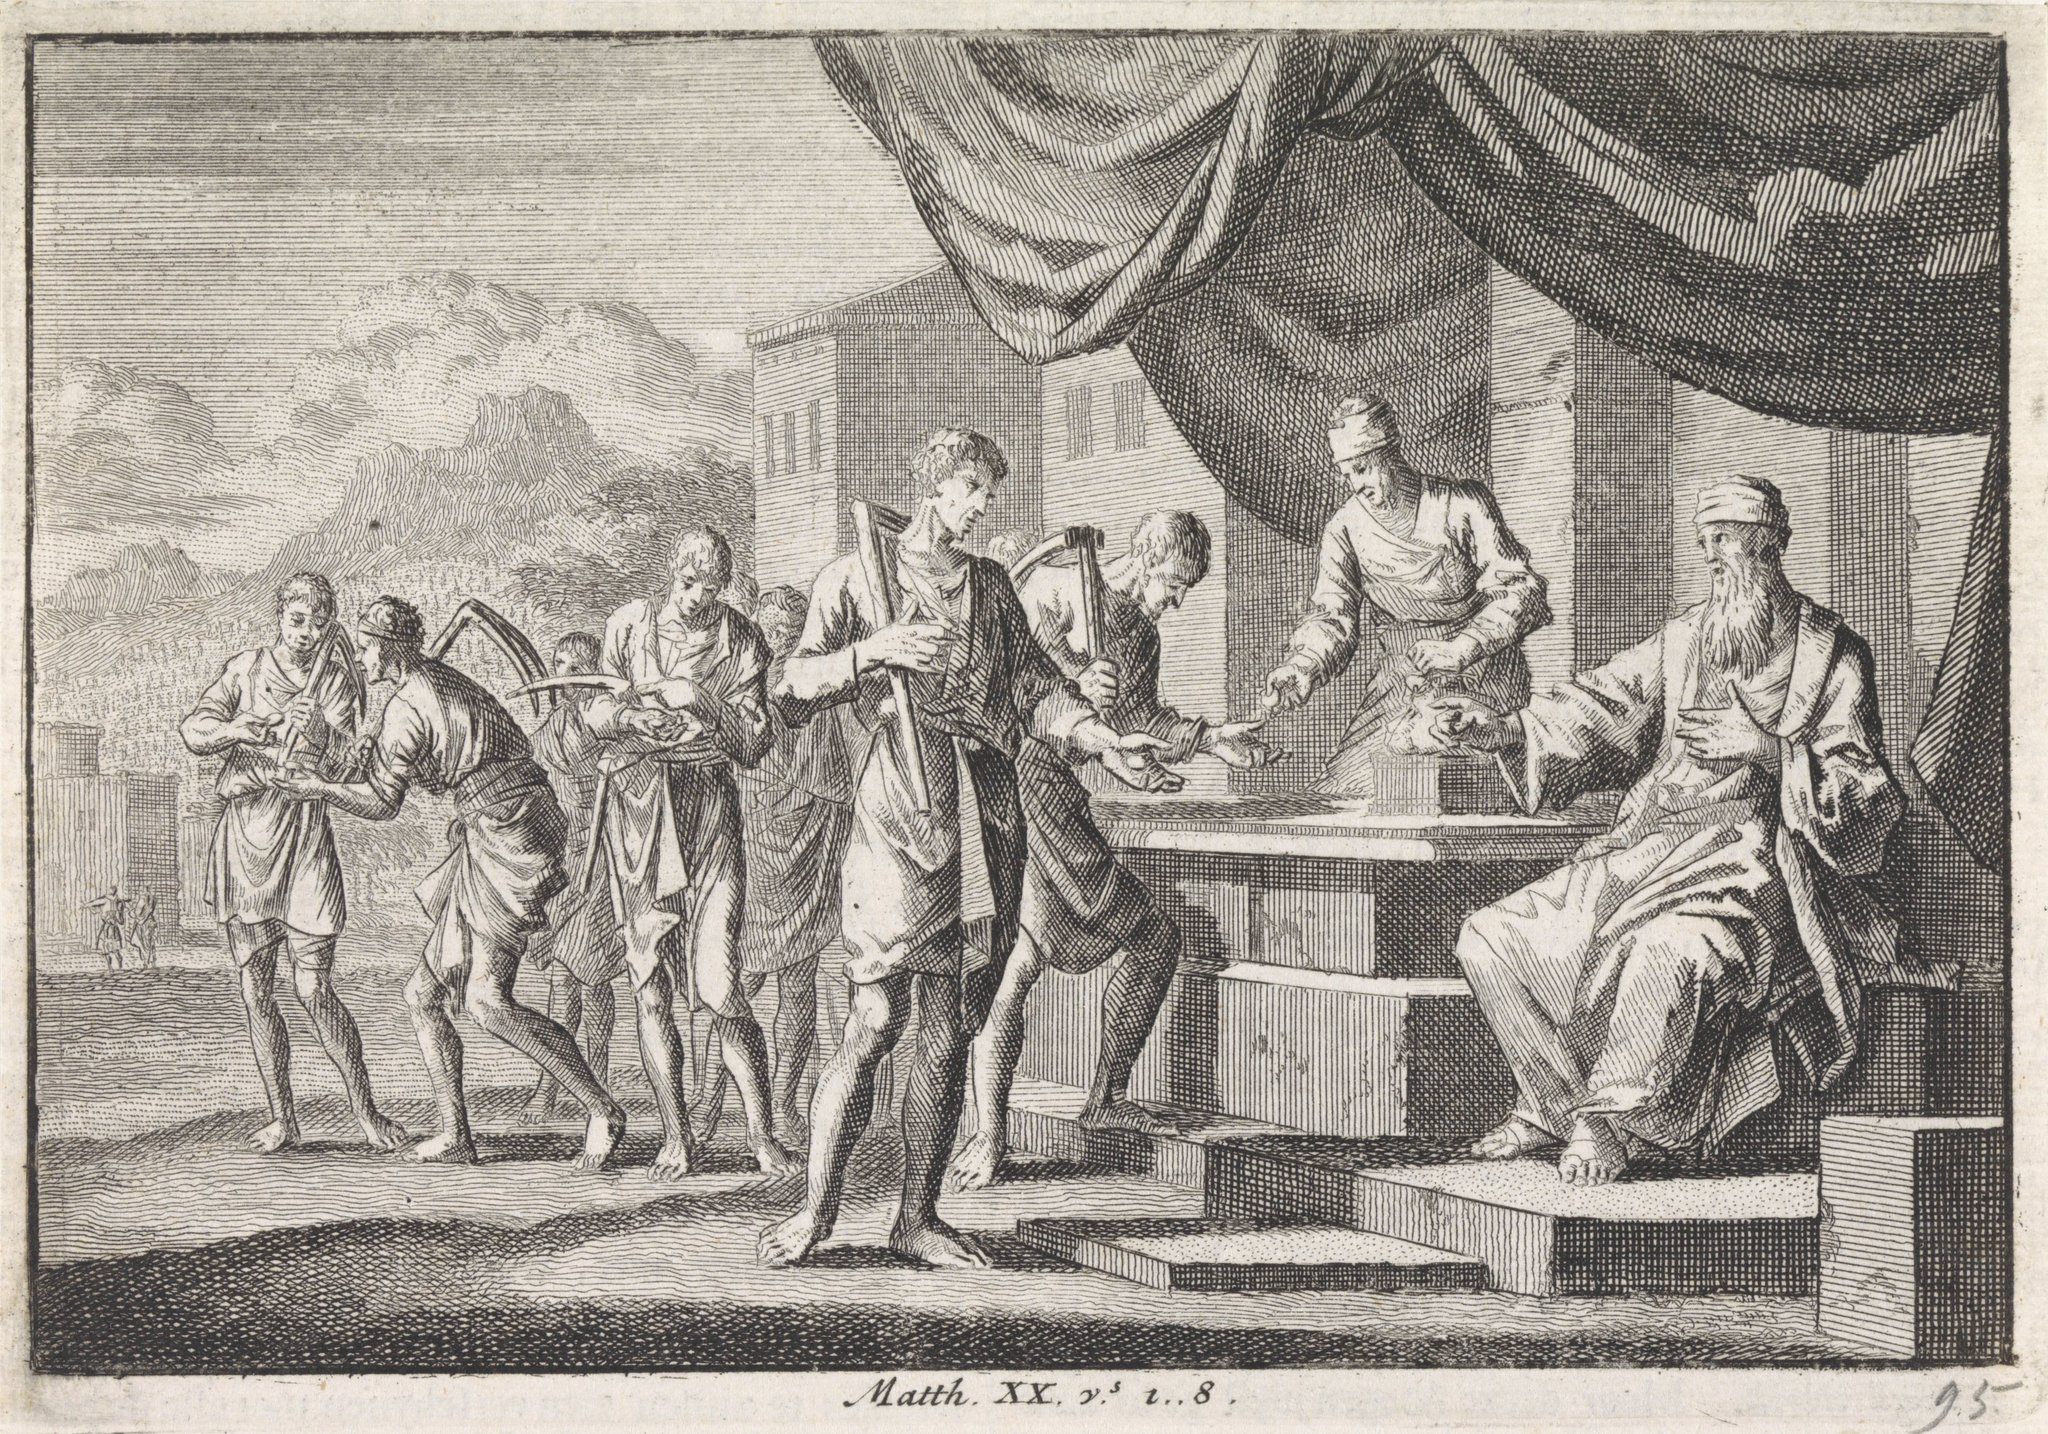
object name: print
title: Gelijkenis van de arbeiders in de wijngaard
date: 1703-1762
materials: paper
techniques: etching, letterpress printing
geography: haarlem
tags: at the end of the day the lord pays all the labourers equally; those that worked all day object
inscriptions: collector's mark: Lugt 2228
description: De prent komt een eerste keer voor als boekillustratie voor David Martin. Historie des Ouden en Nieuwen Testaments. Amsterdam, Pieter Mortier, 1703. Deel II. De boekillustraties voor de Mortierbijbel hebben verschillende staten en kopieën, waarbij de chronologische volgorde moeilijk te achterhalen valt. Als boekillustraties werden ze bovendien herhaaldelijk opnieuw gebruikt voor andere boekwerken.